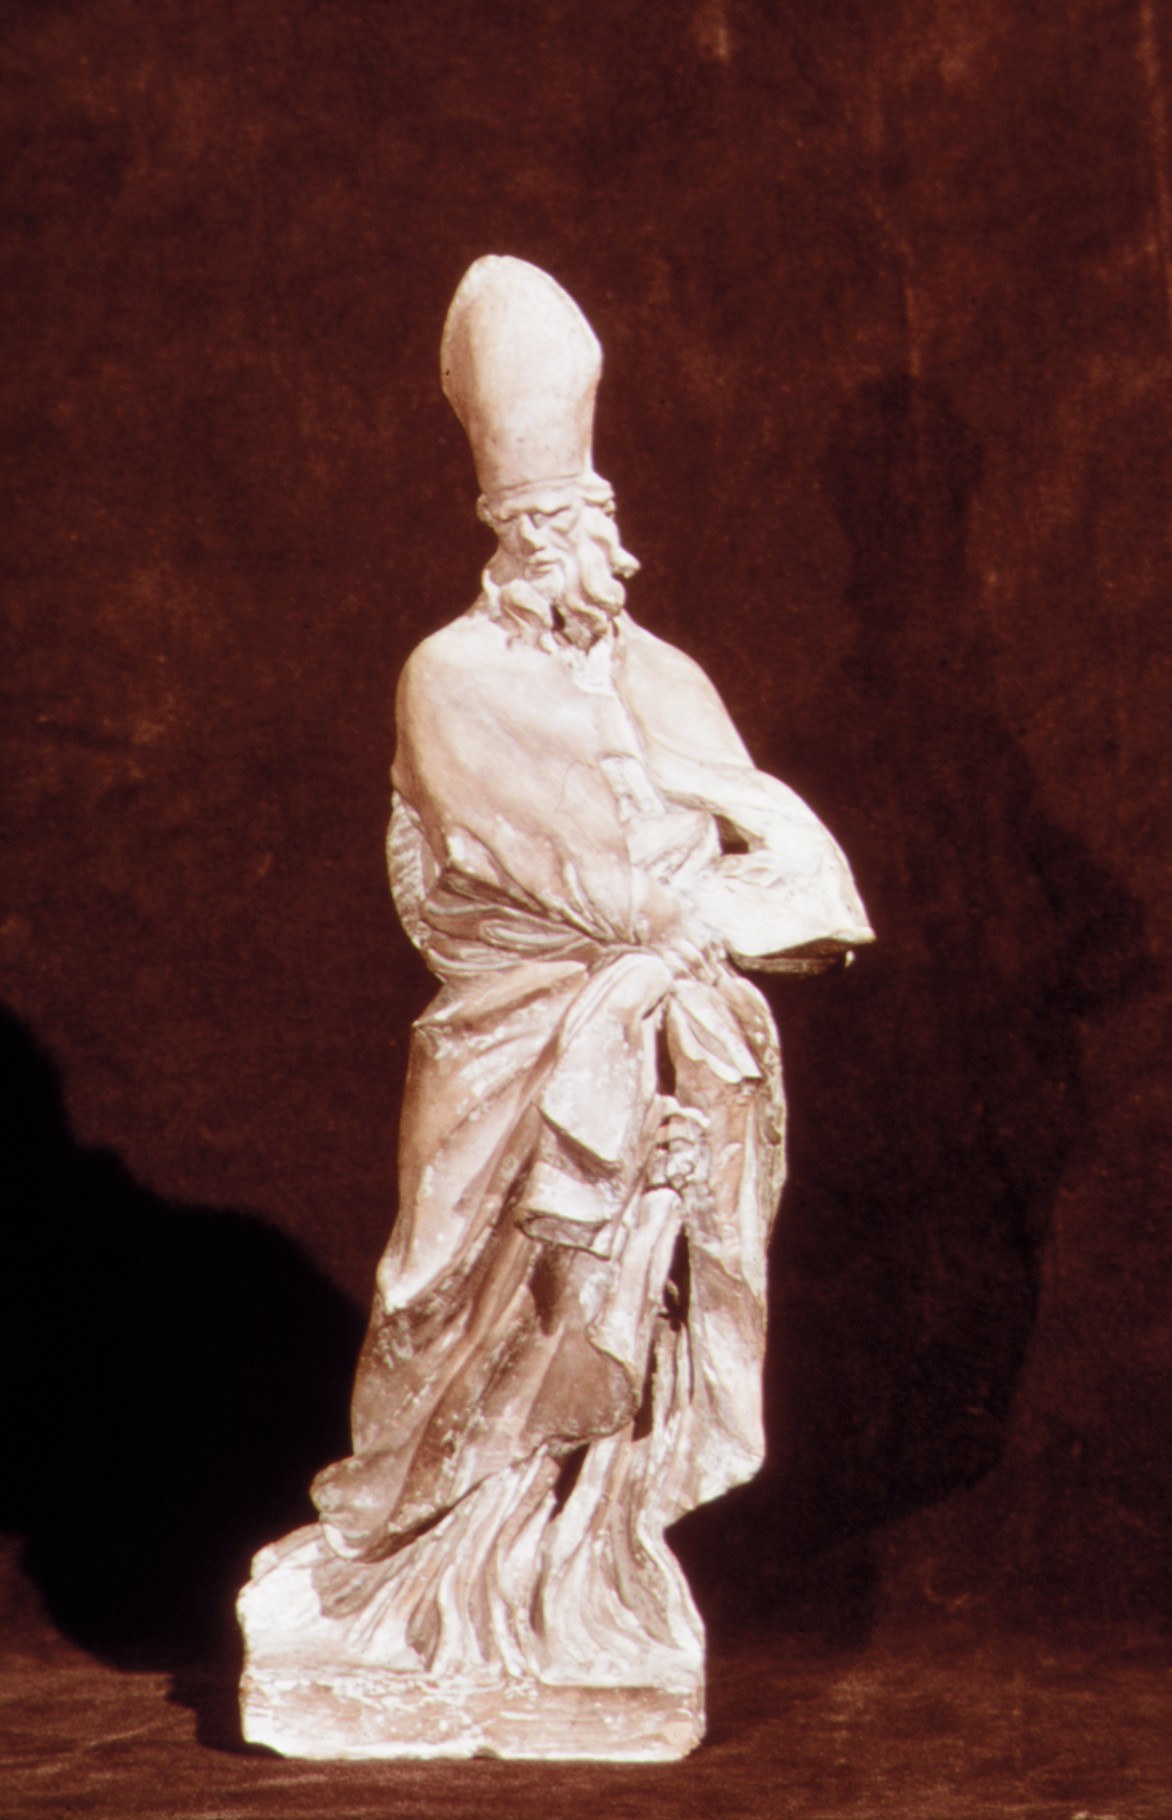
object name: sketch model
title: Bishop Saint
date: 1651-1700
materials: terracotta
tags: bishops,saints